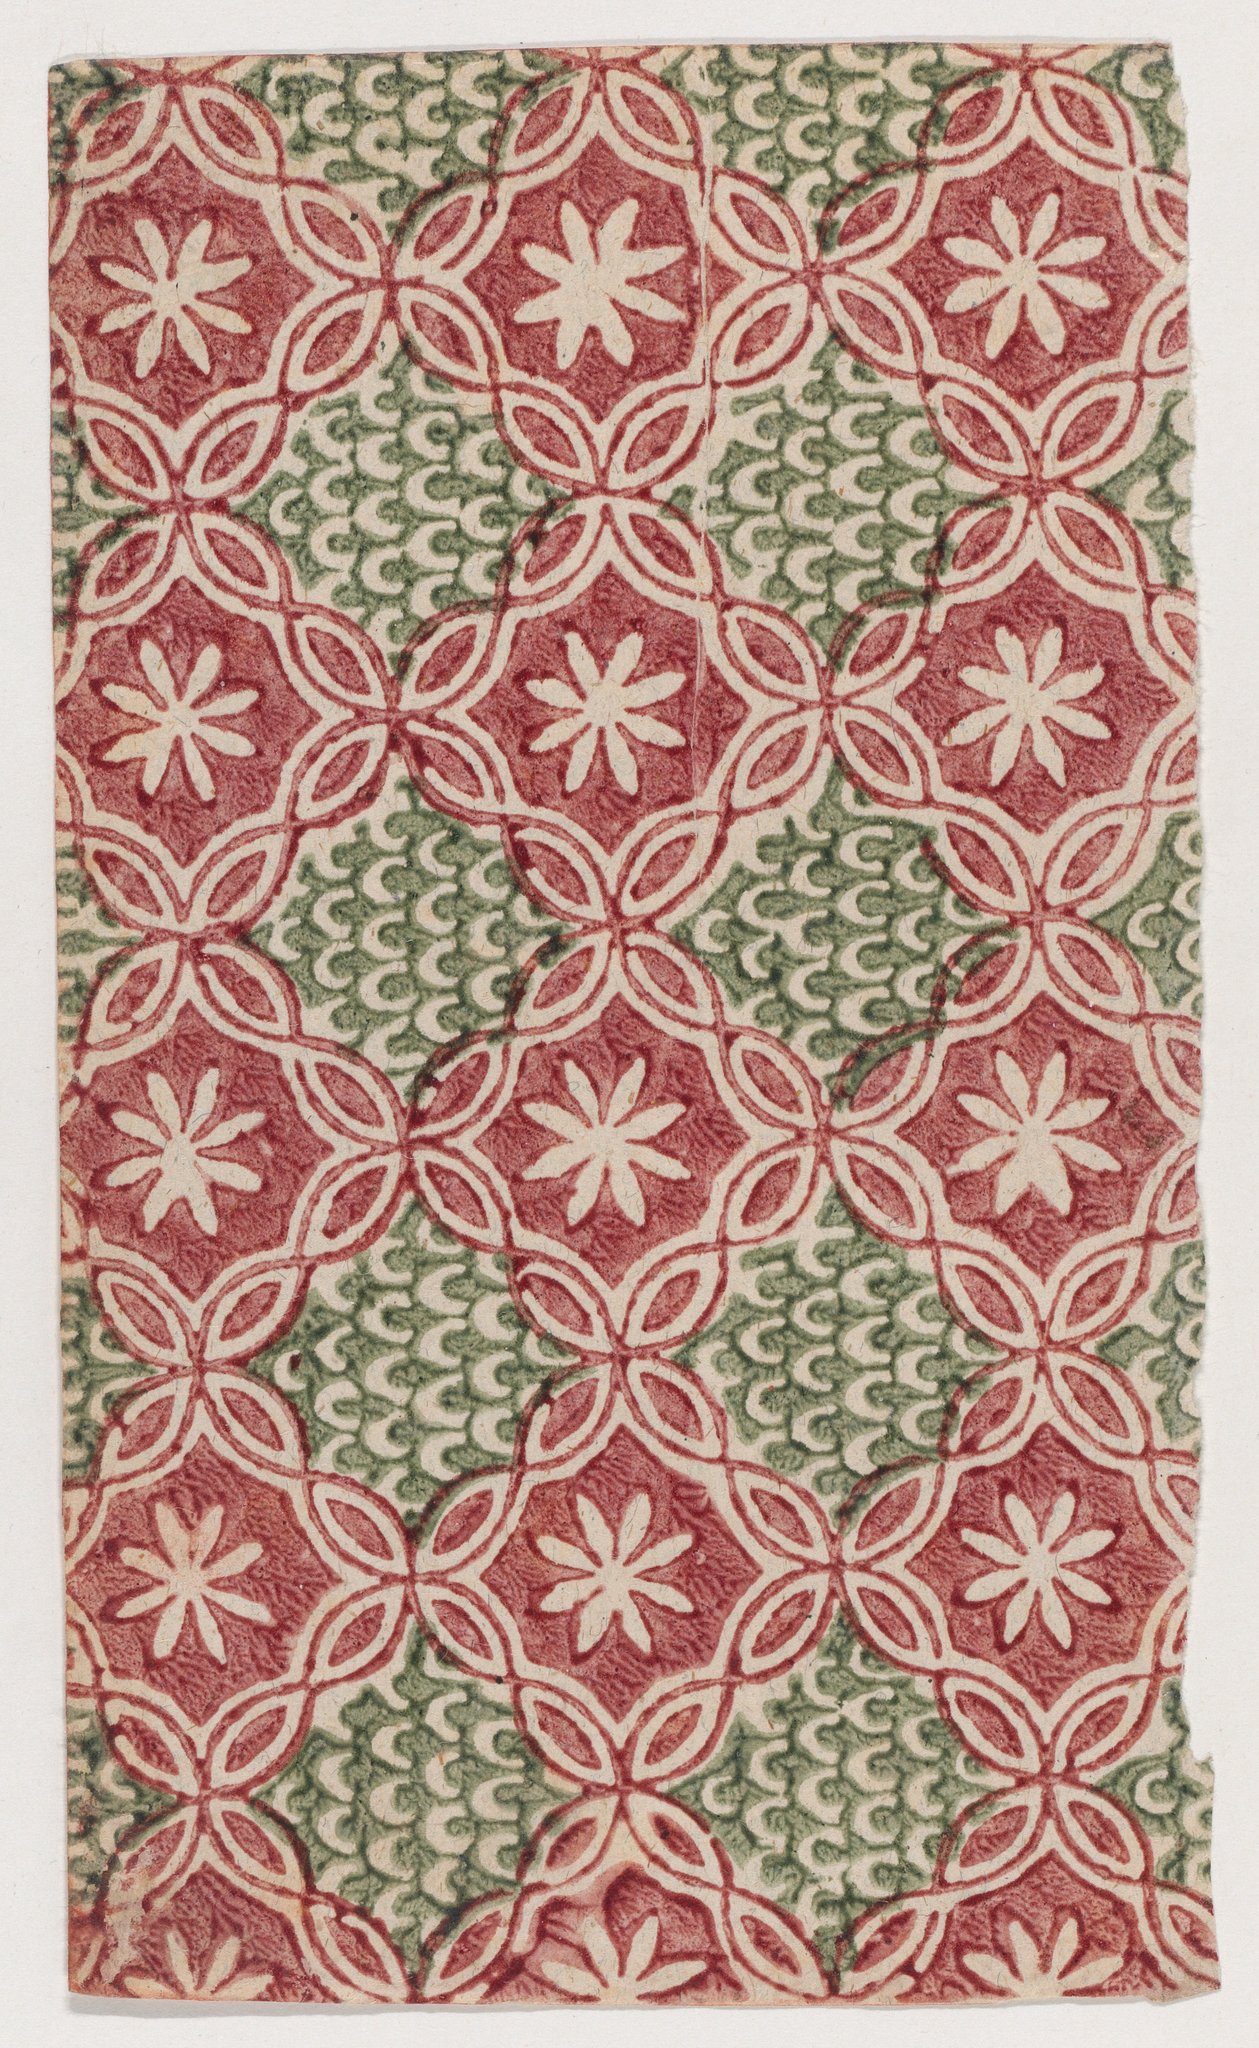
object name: print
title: Sheet with overall floral and U shaped patterns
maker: Anonymous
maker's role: artist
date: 1801-1900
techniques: relief print